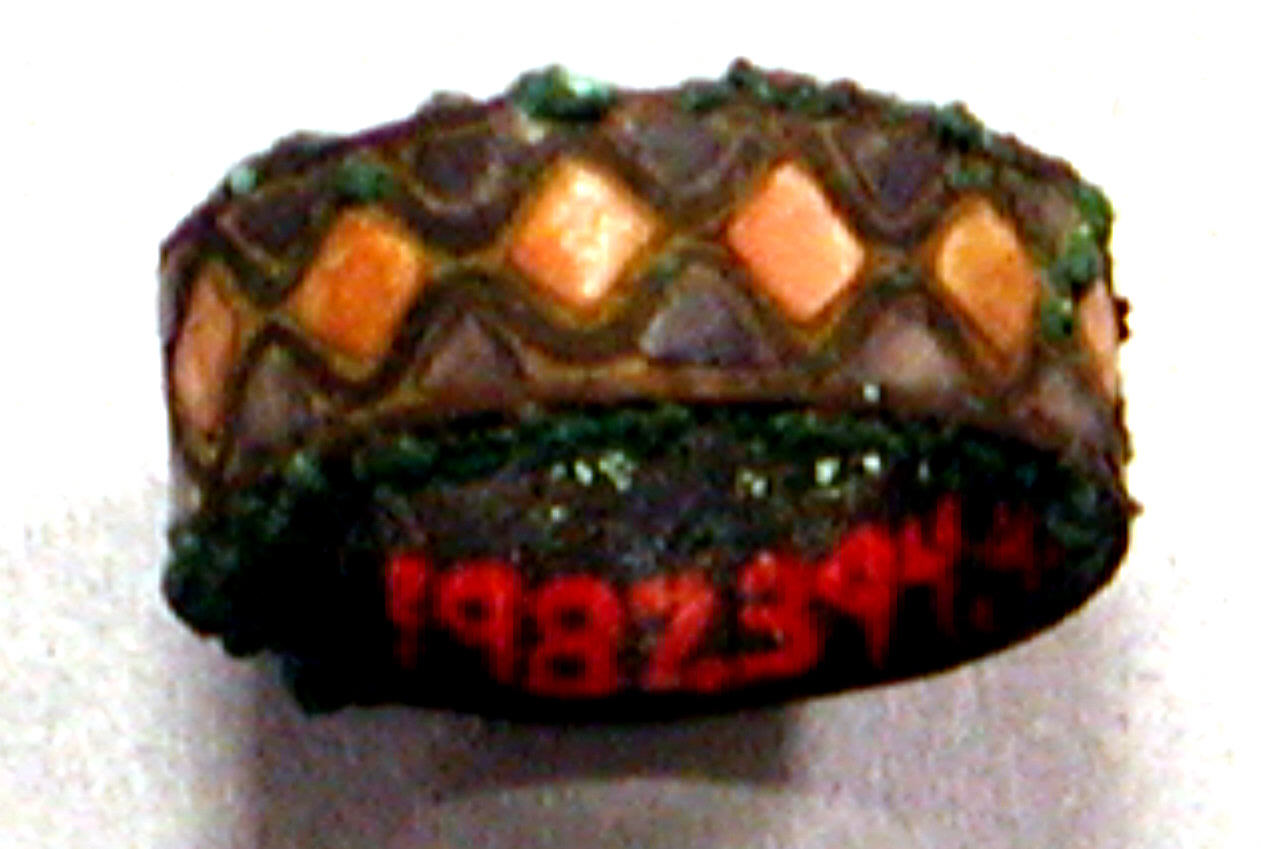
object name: ring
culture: moche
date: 101-700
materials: copper, gilt, shell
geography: peru